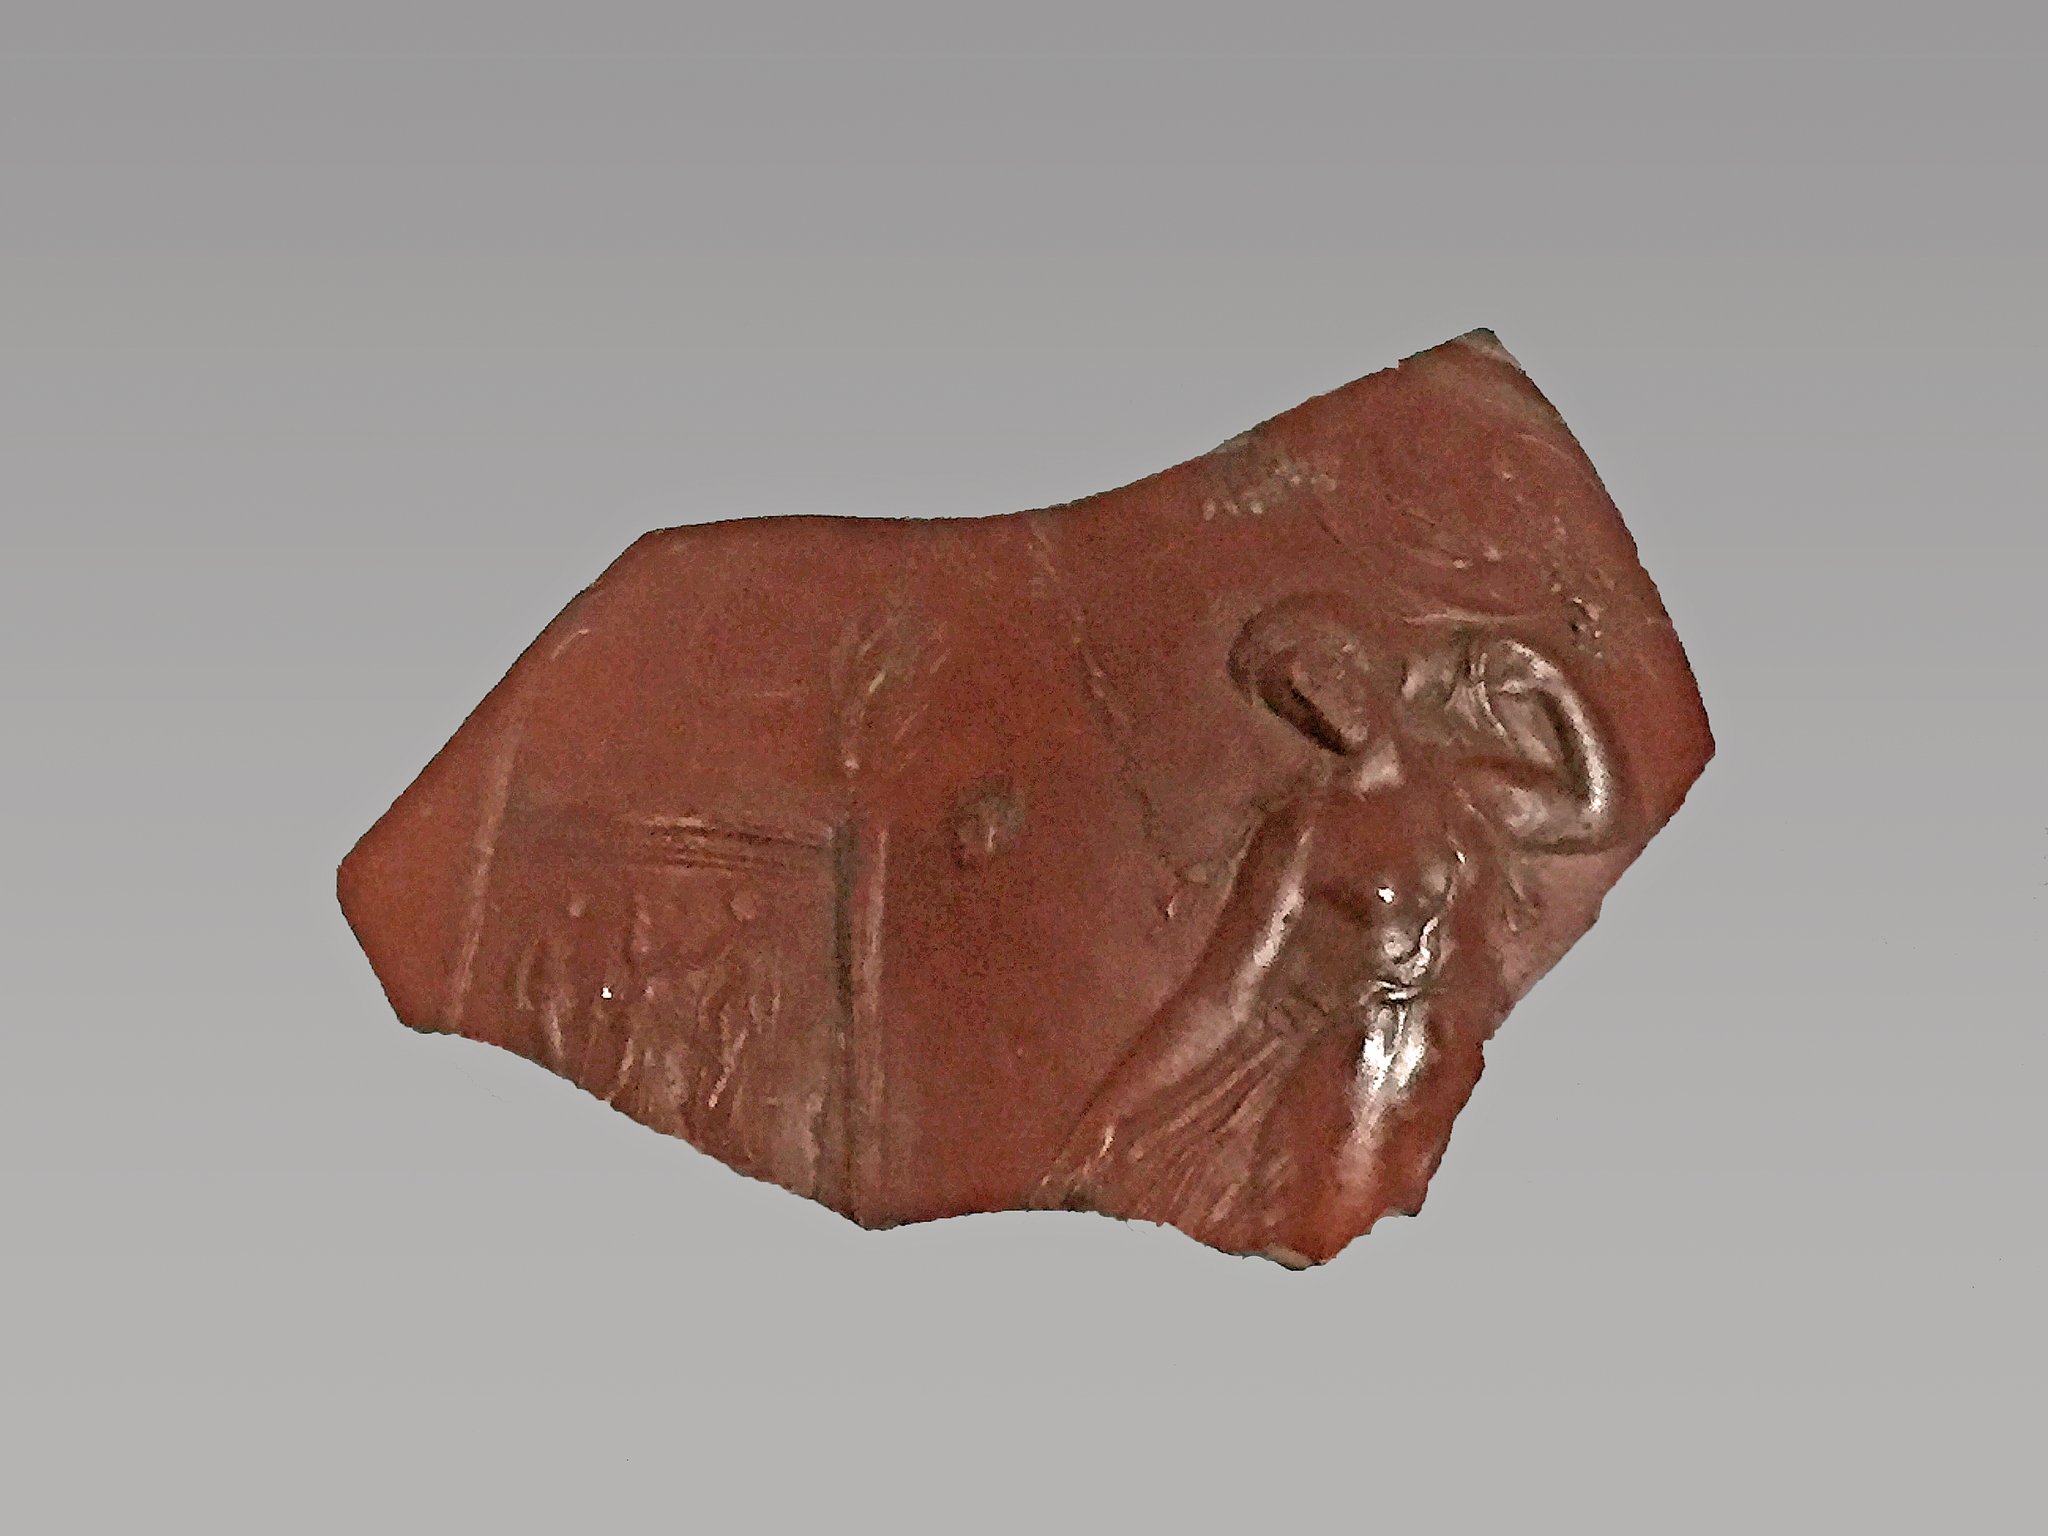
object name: vase fragment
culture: roman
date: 31 BCE-14 CE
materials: terracotta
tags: women